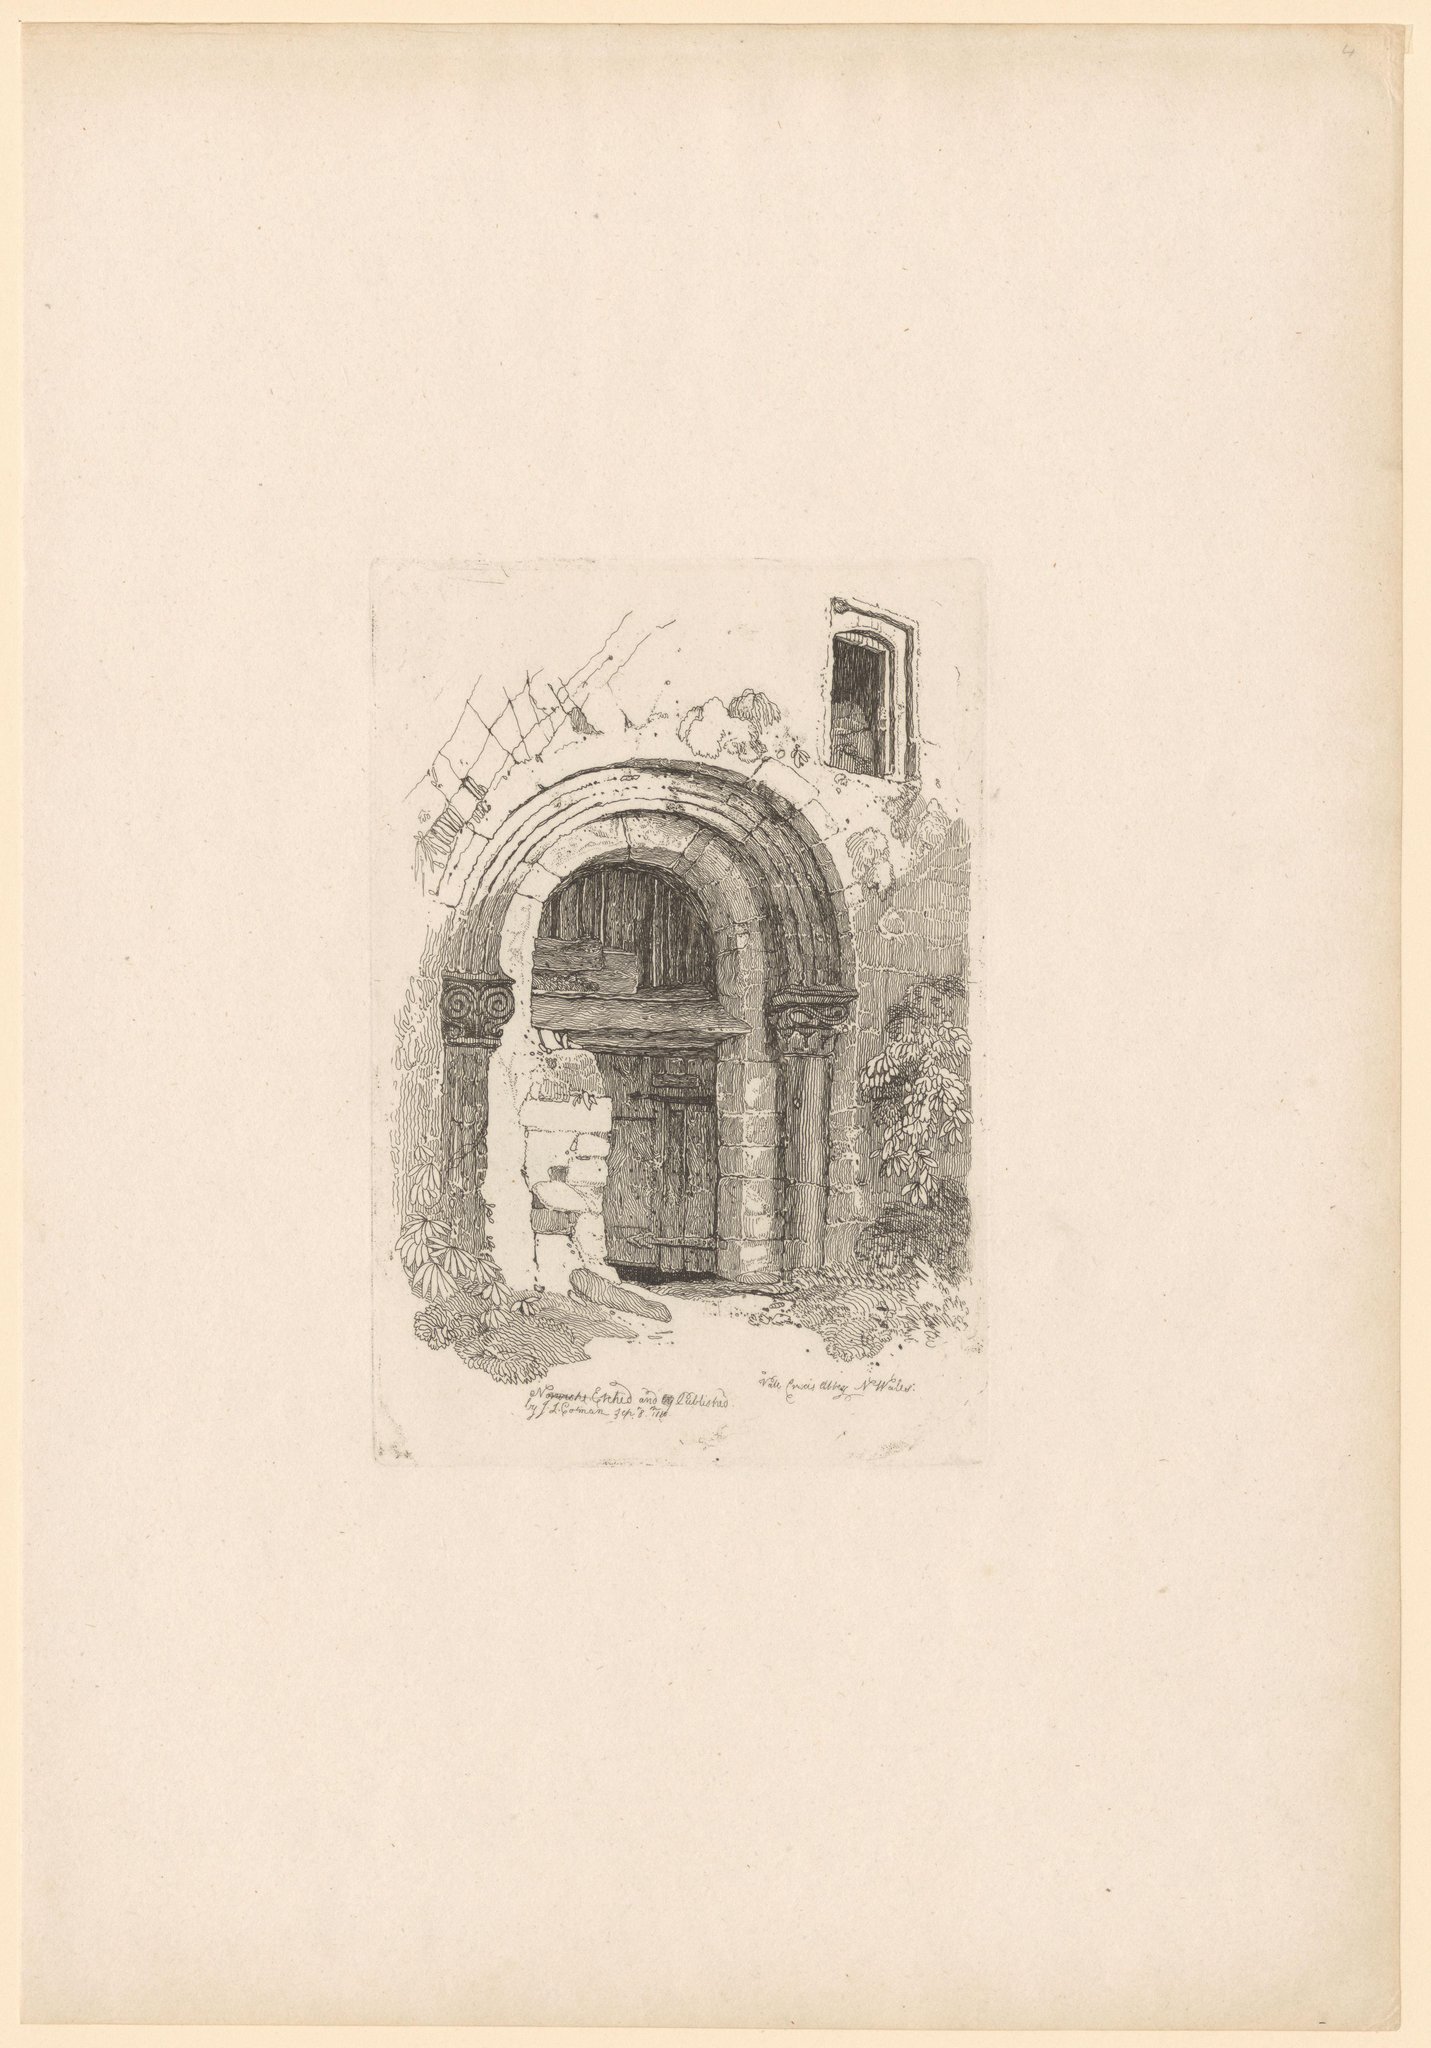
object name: print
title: Etsen door John Sell Cotman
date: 1809-1810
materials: paper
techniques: etching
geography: york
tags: abbey, monastery, convent ~ roman catholic church, gate, entrance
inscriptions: collector's mark: Lugt 2228, collector's mark: Lugt 2760